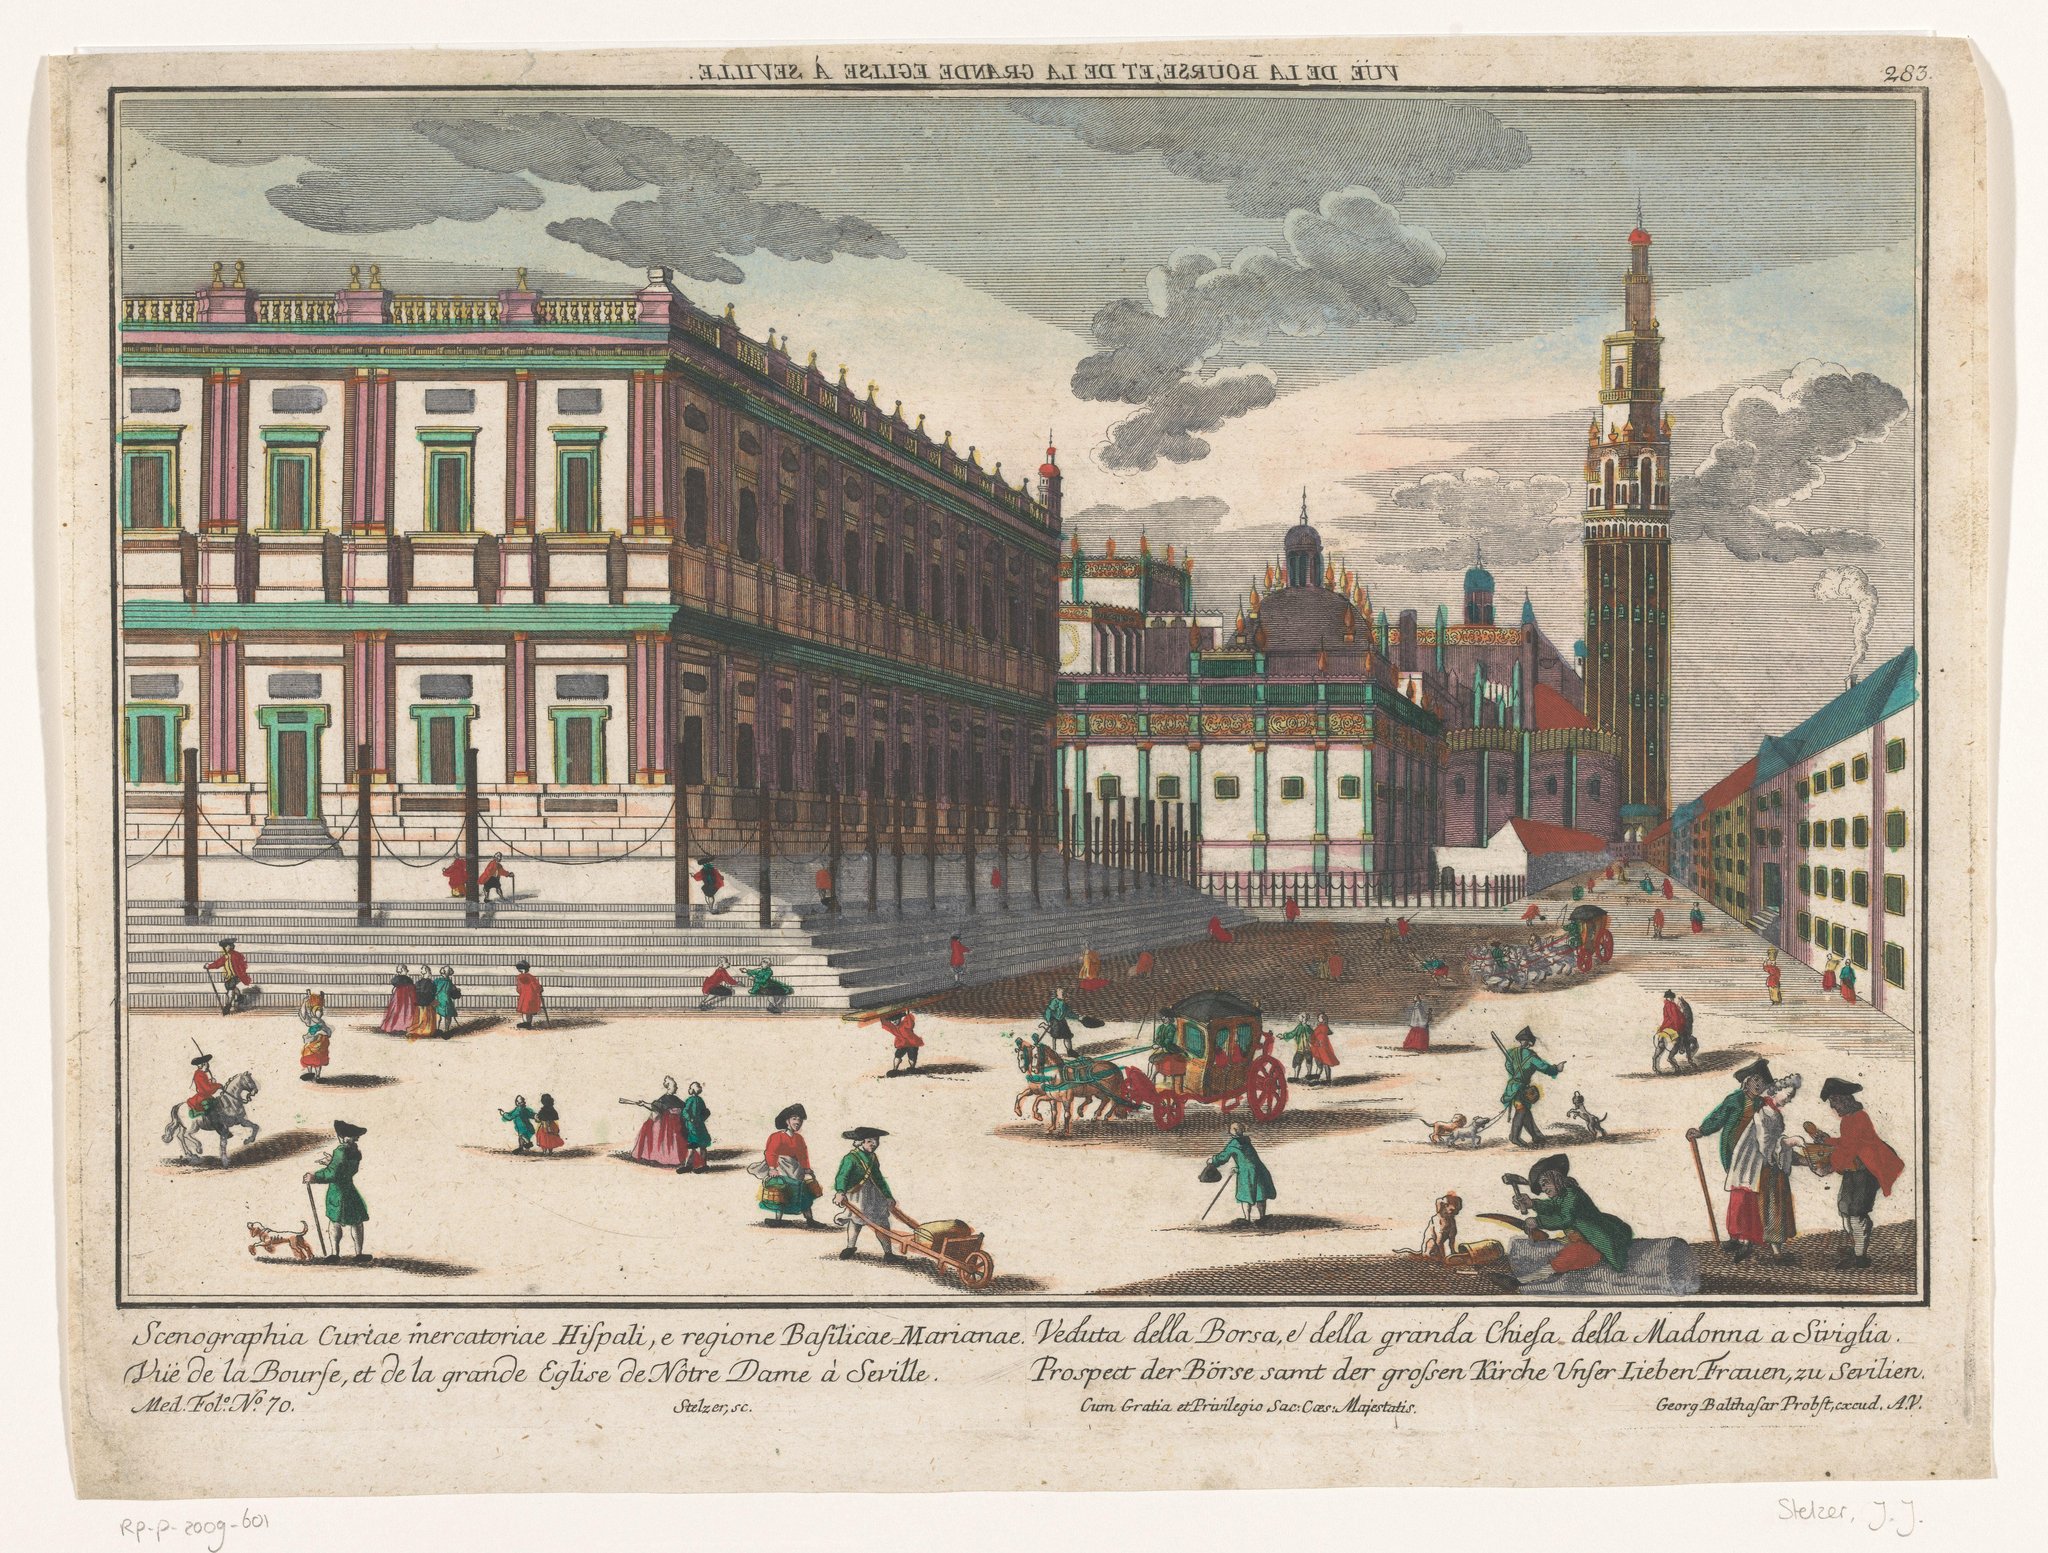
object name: opticaprent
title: Sevilla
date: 1742-1801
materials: paper, watercolor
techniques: brush, etching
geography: augsburg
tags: building of church, exchange, bourse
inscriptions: collector's mark: Lugt 2228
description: Gezicht op een plein met links de Beurs en op de achtergrond de toren van de Santa María de la Sede. Op het plein wandelaars, koetsen en handwerkslieden. Onder de afbeelding de titel in vier talen